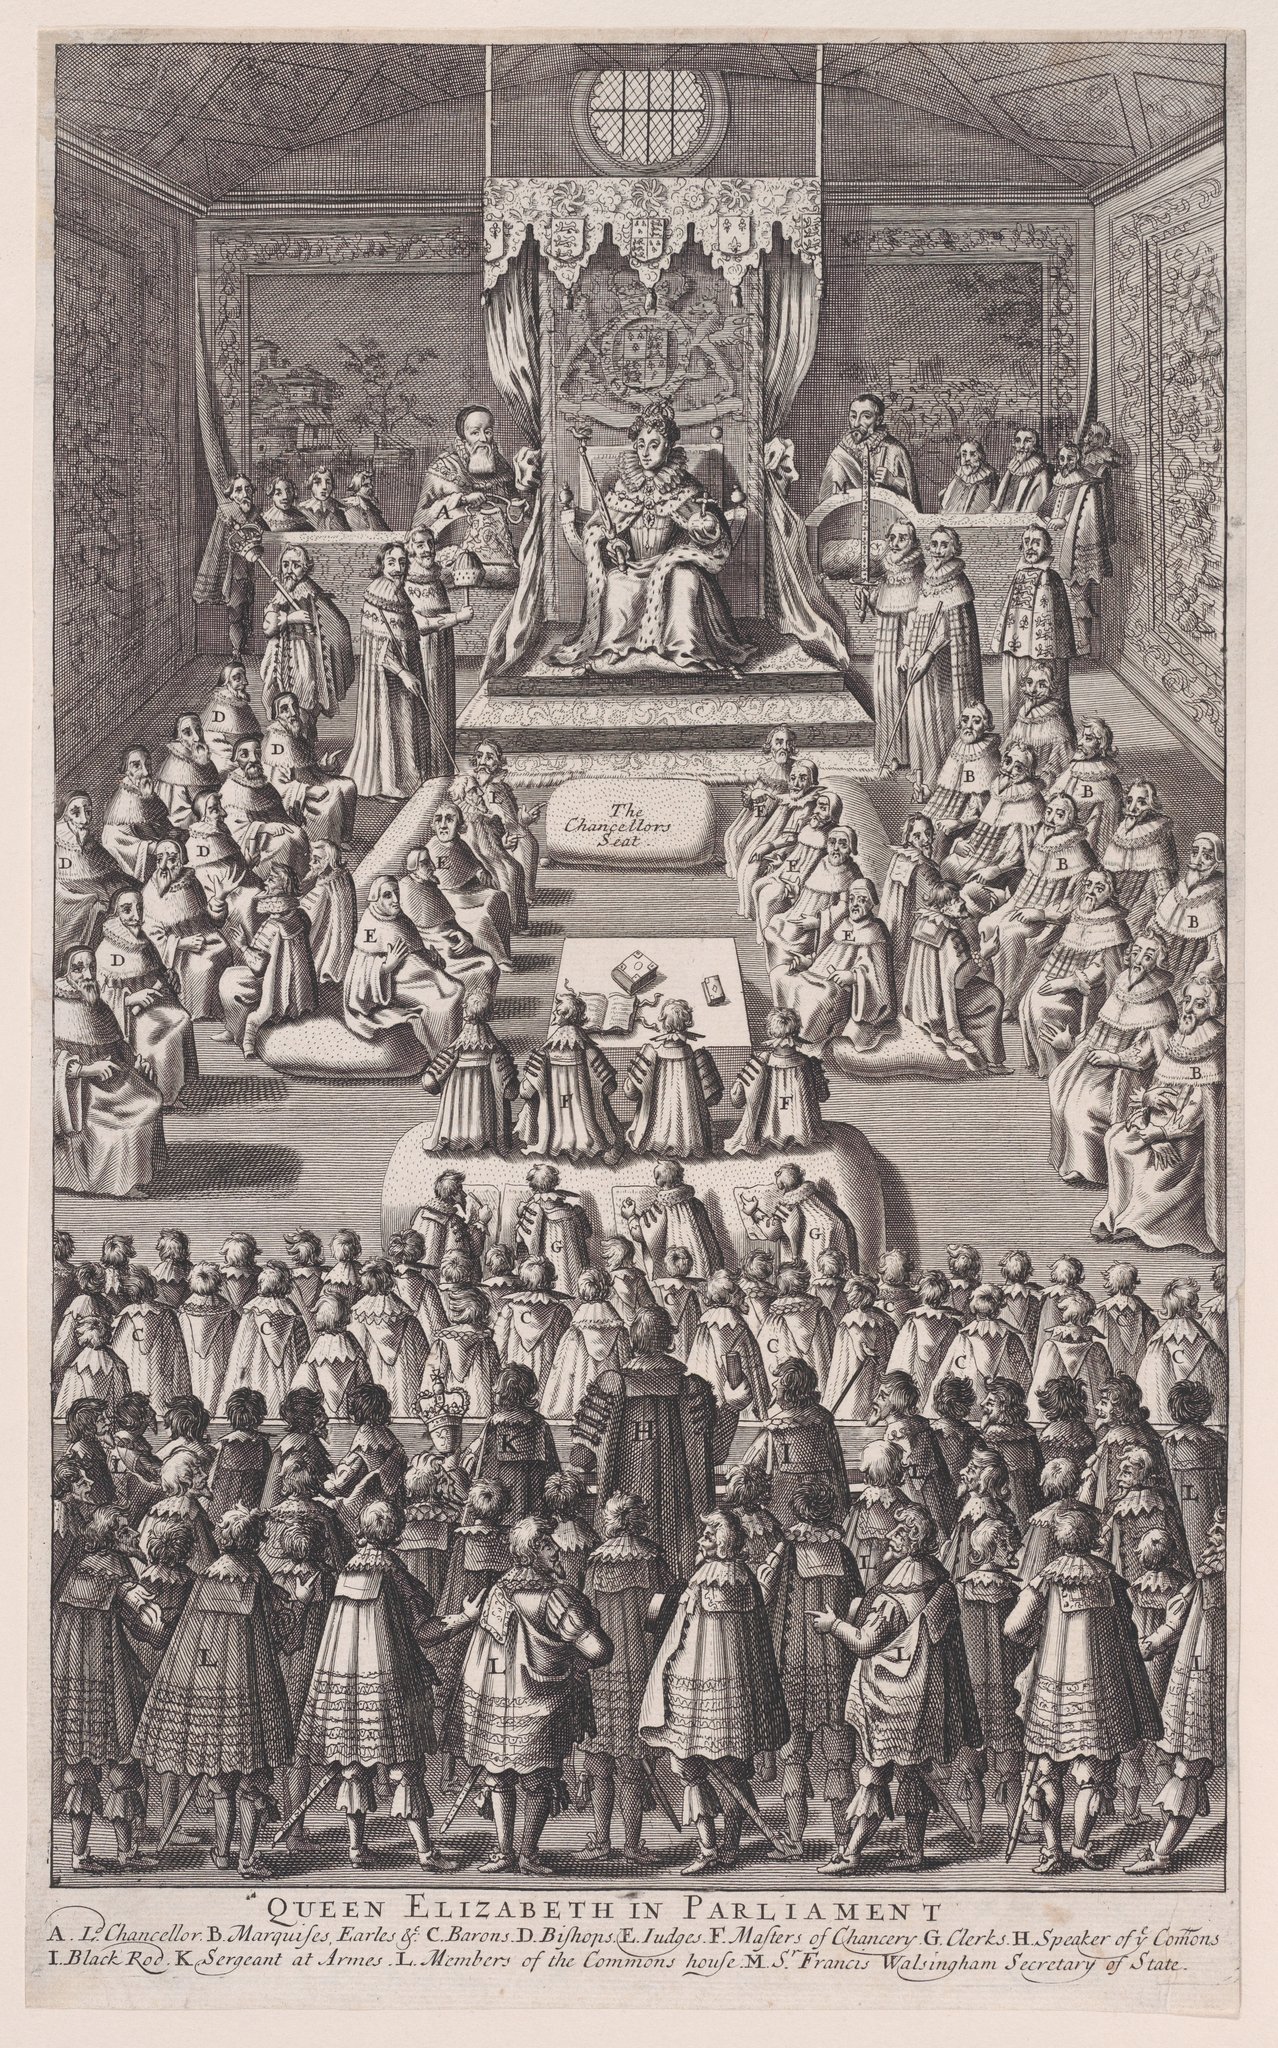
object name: print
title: Queen Elizabeth in Parliament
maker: anonymous, 17th century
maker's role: engraver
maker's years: 1600-1700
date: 1682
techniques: engraving